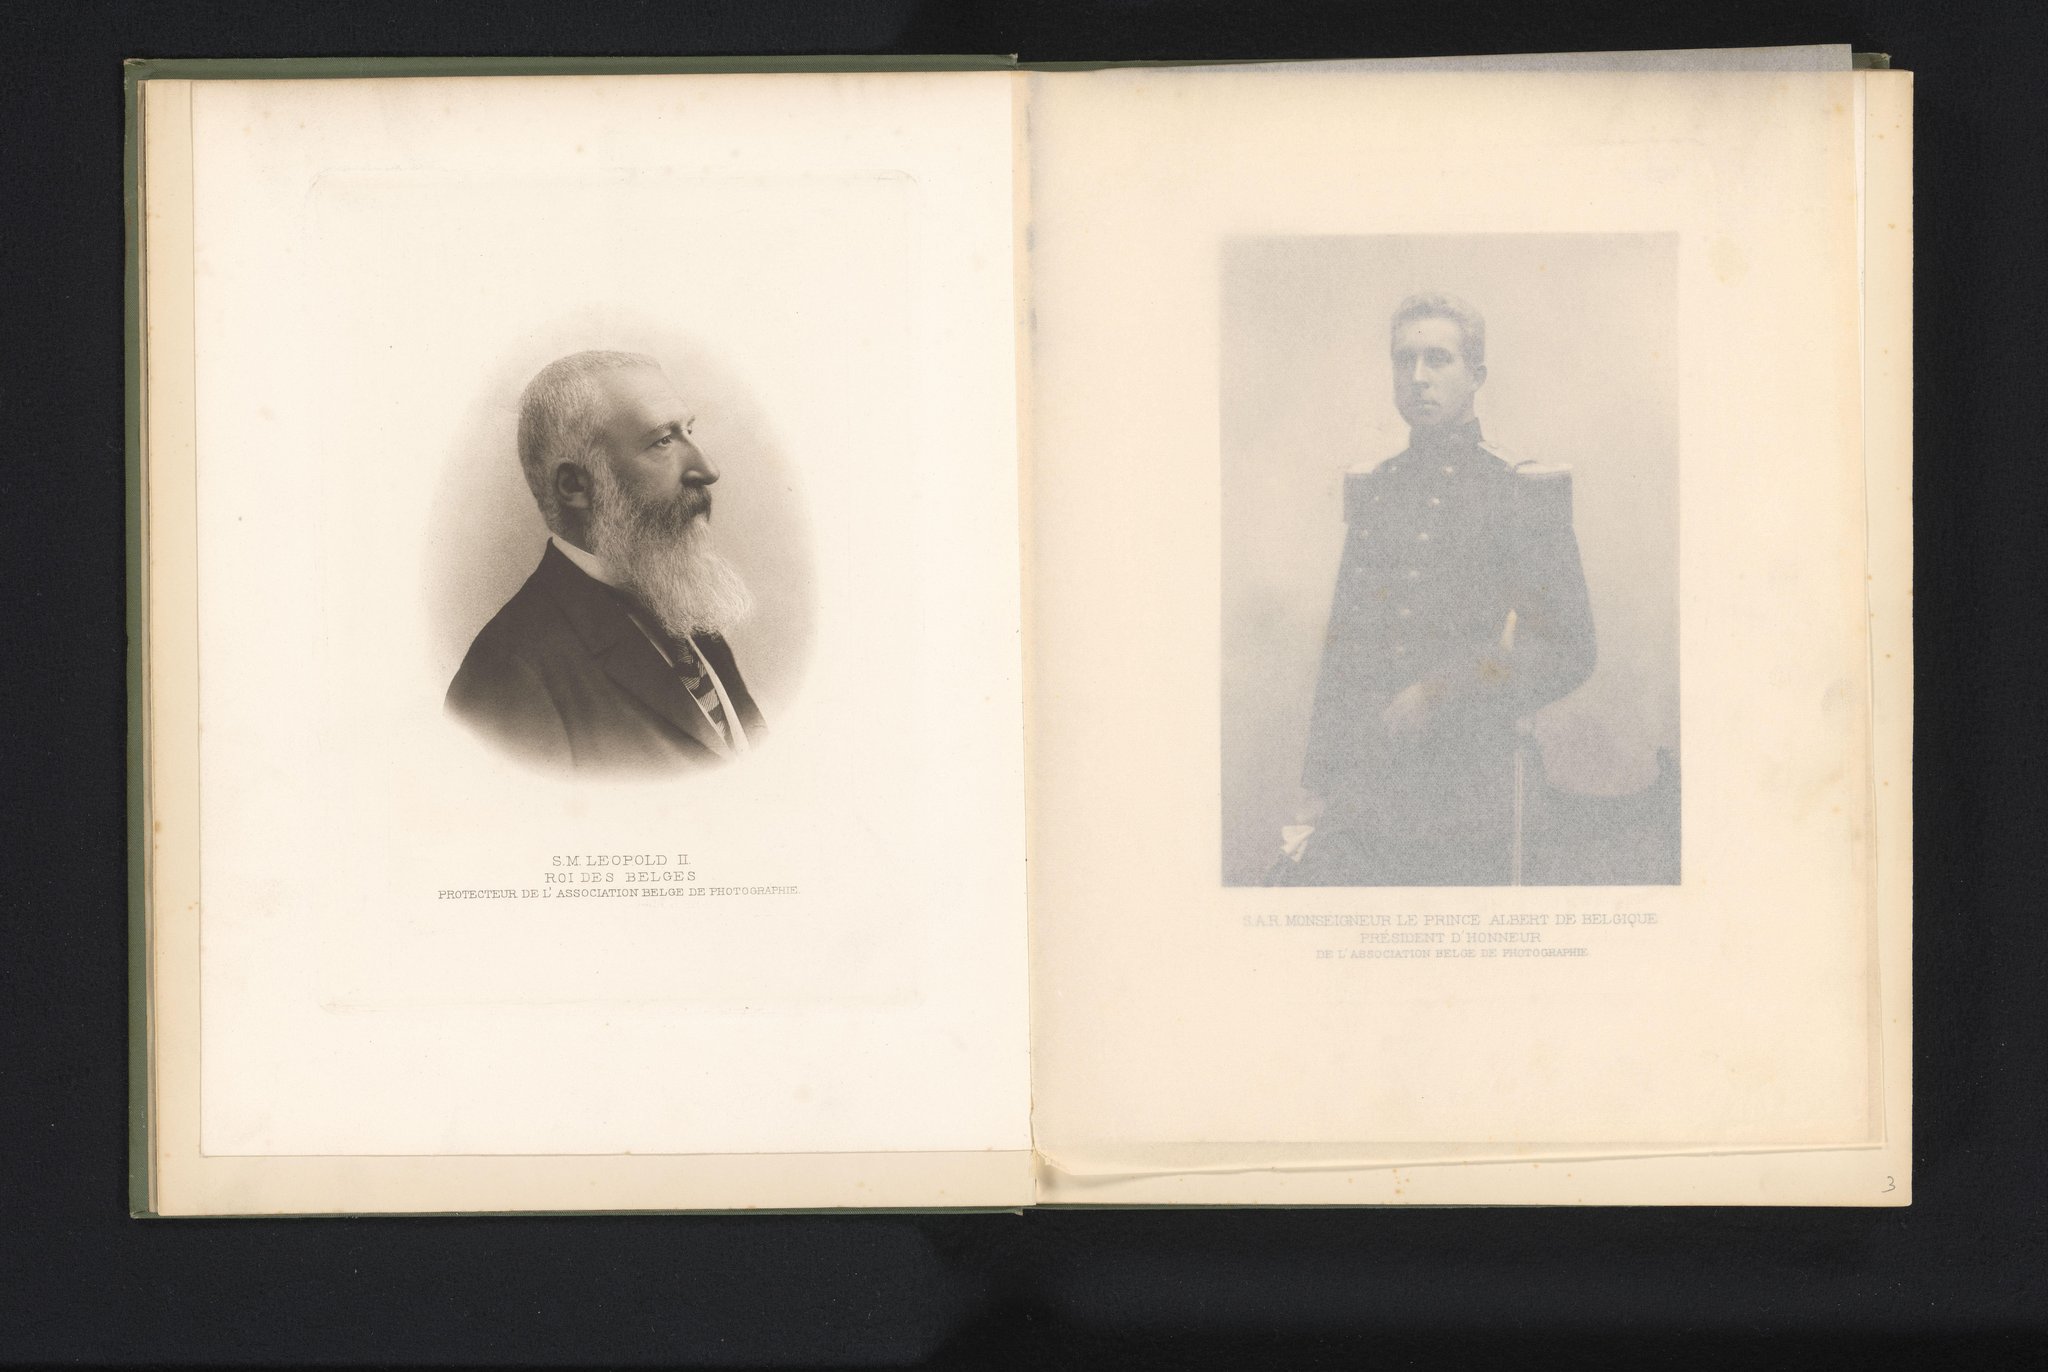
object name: photomechanical print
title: S.M. Leopold II, Roi des Belges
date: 1893-1898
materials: paper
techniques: photoaquatint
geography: vienna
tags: leopold ii (koning der belgen), historical persons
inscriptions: inscription: ‘Protecteur de l'association Belge de photographie’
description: Prent op derde ongenummerde pagina na titelpagina.